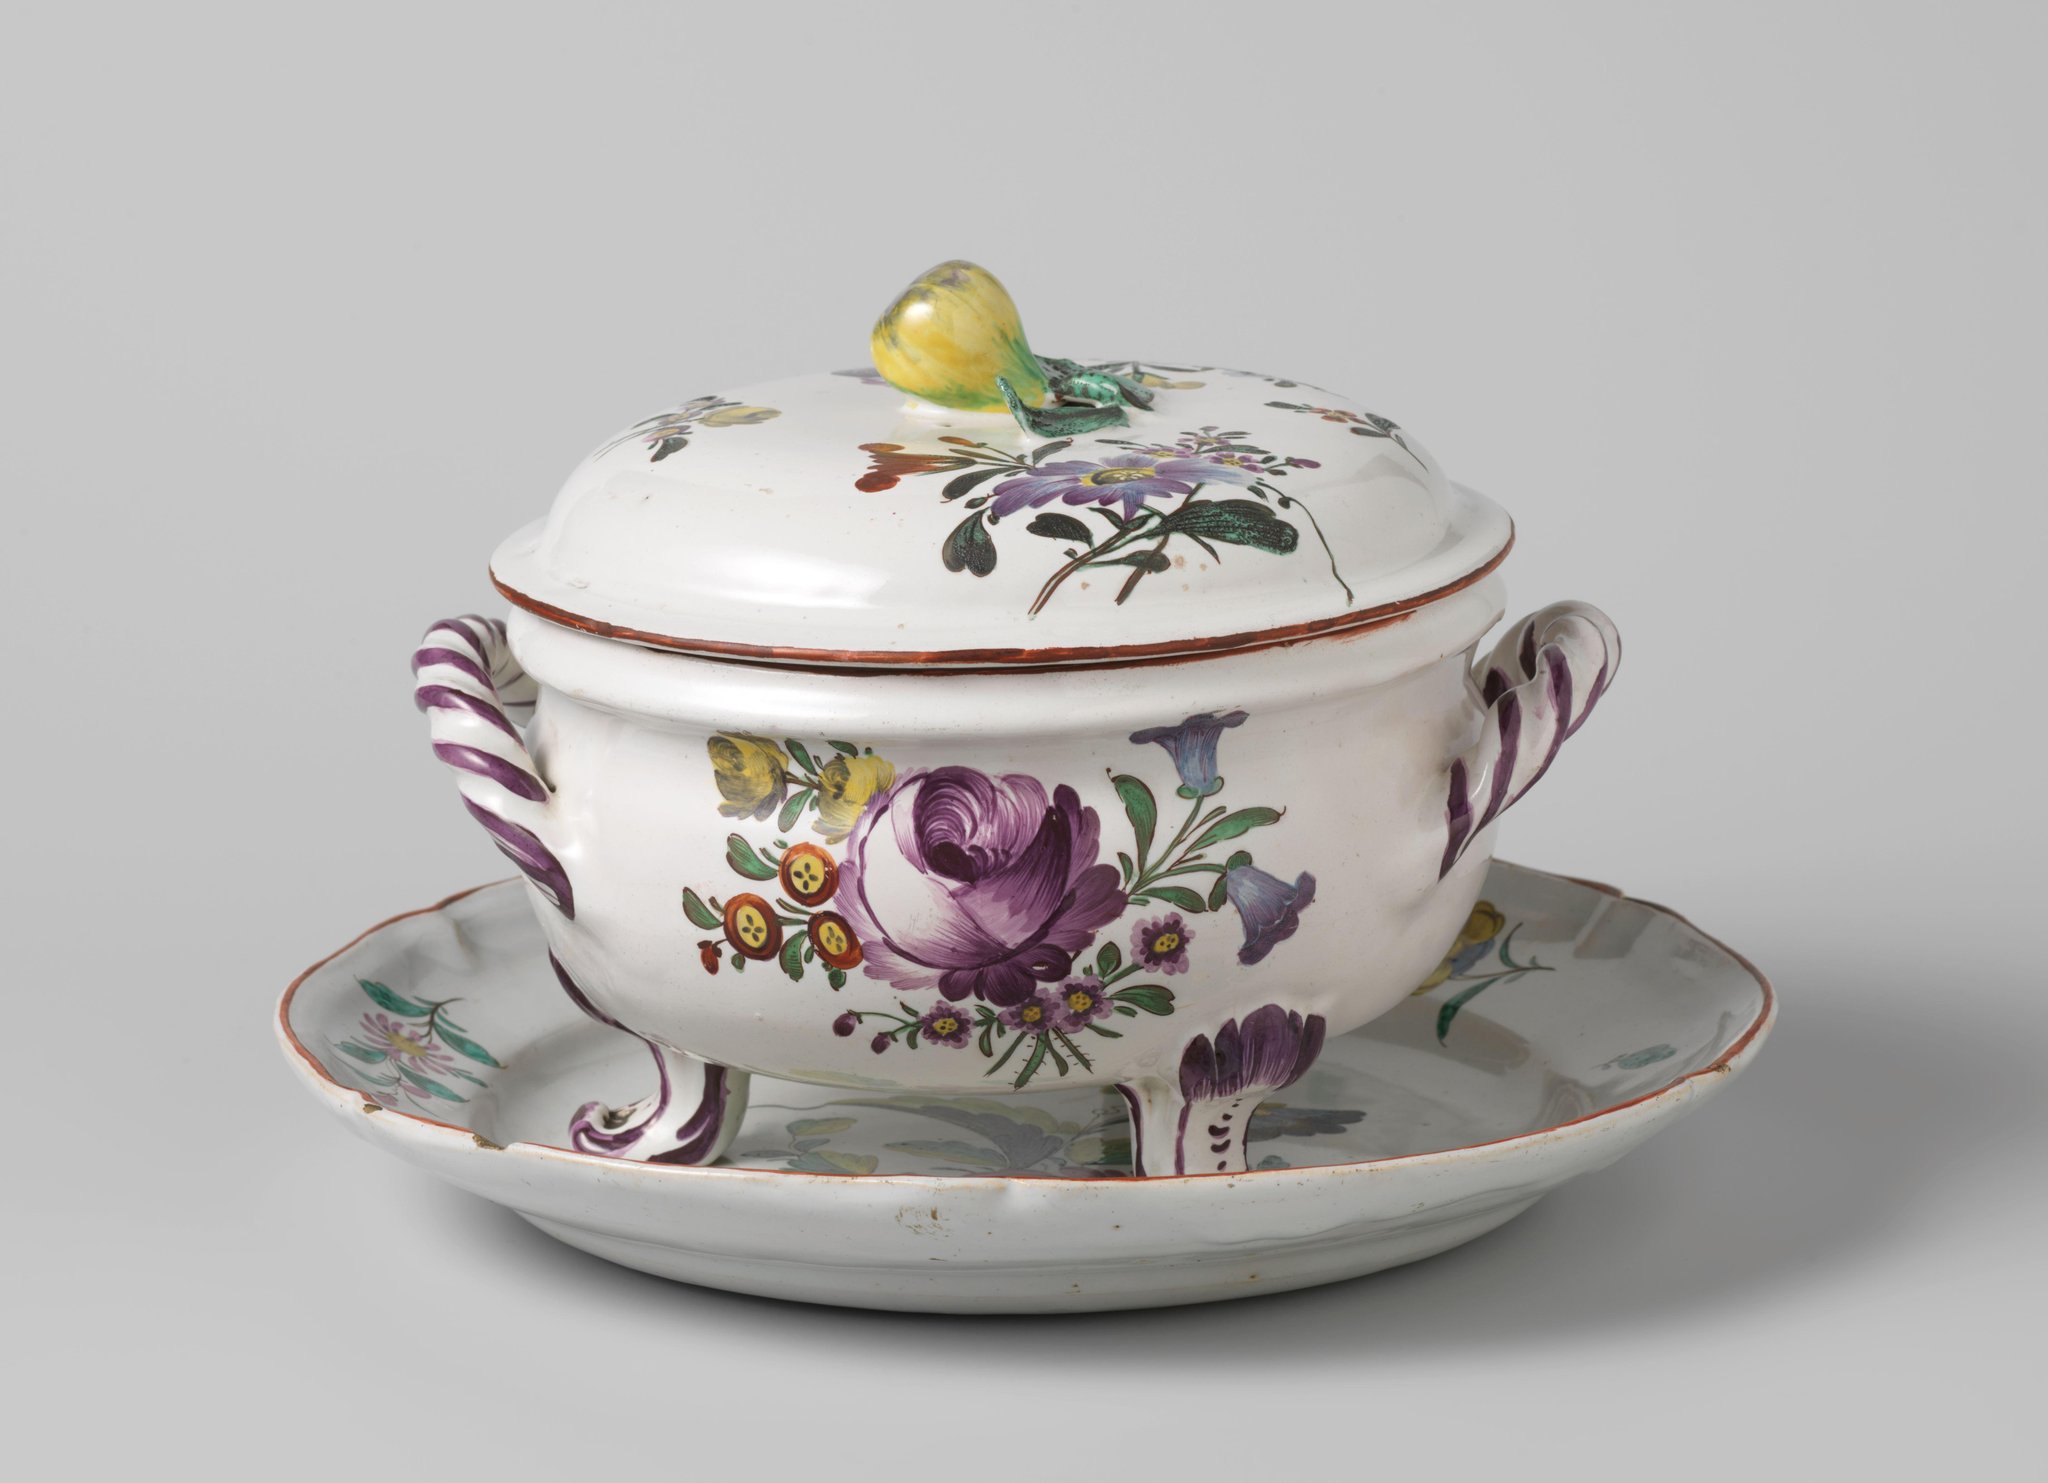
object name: tureen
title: Terrine, veelkleurig beschilderd met een bloemboeket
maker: johan van kerkhoff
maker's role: fayencier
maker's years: 1716-1773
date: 1760-1770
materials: faience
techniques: kiln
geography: arnhem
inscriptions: mark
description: Terrine van faience, veelkleurig beschilderd met een bloemboeket. Langs de randen, bloemtakken.